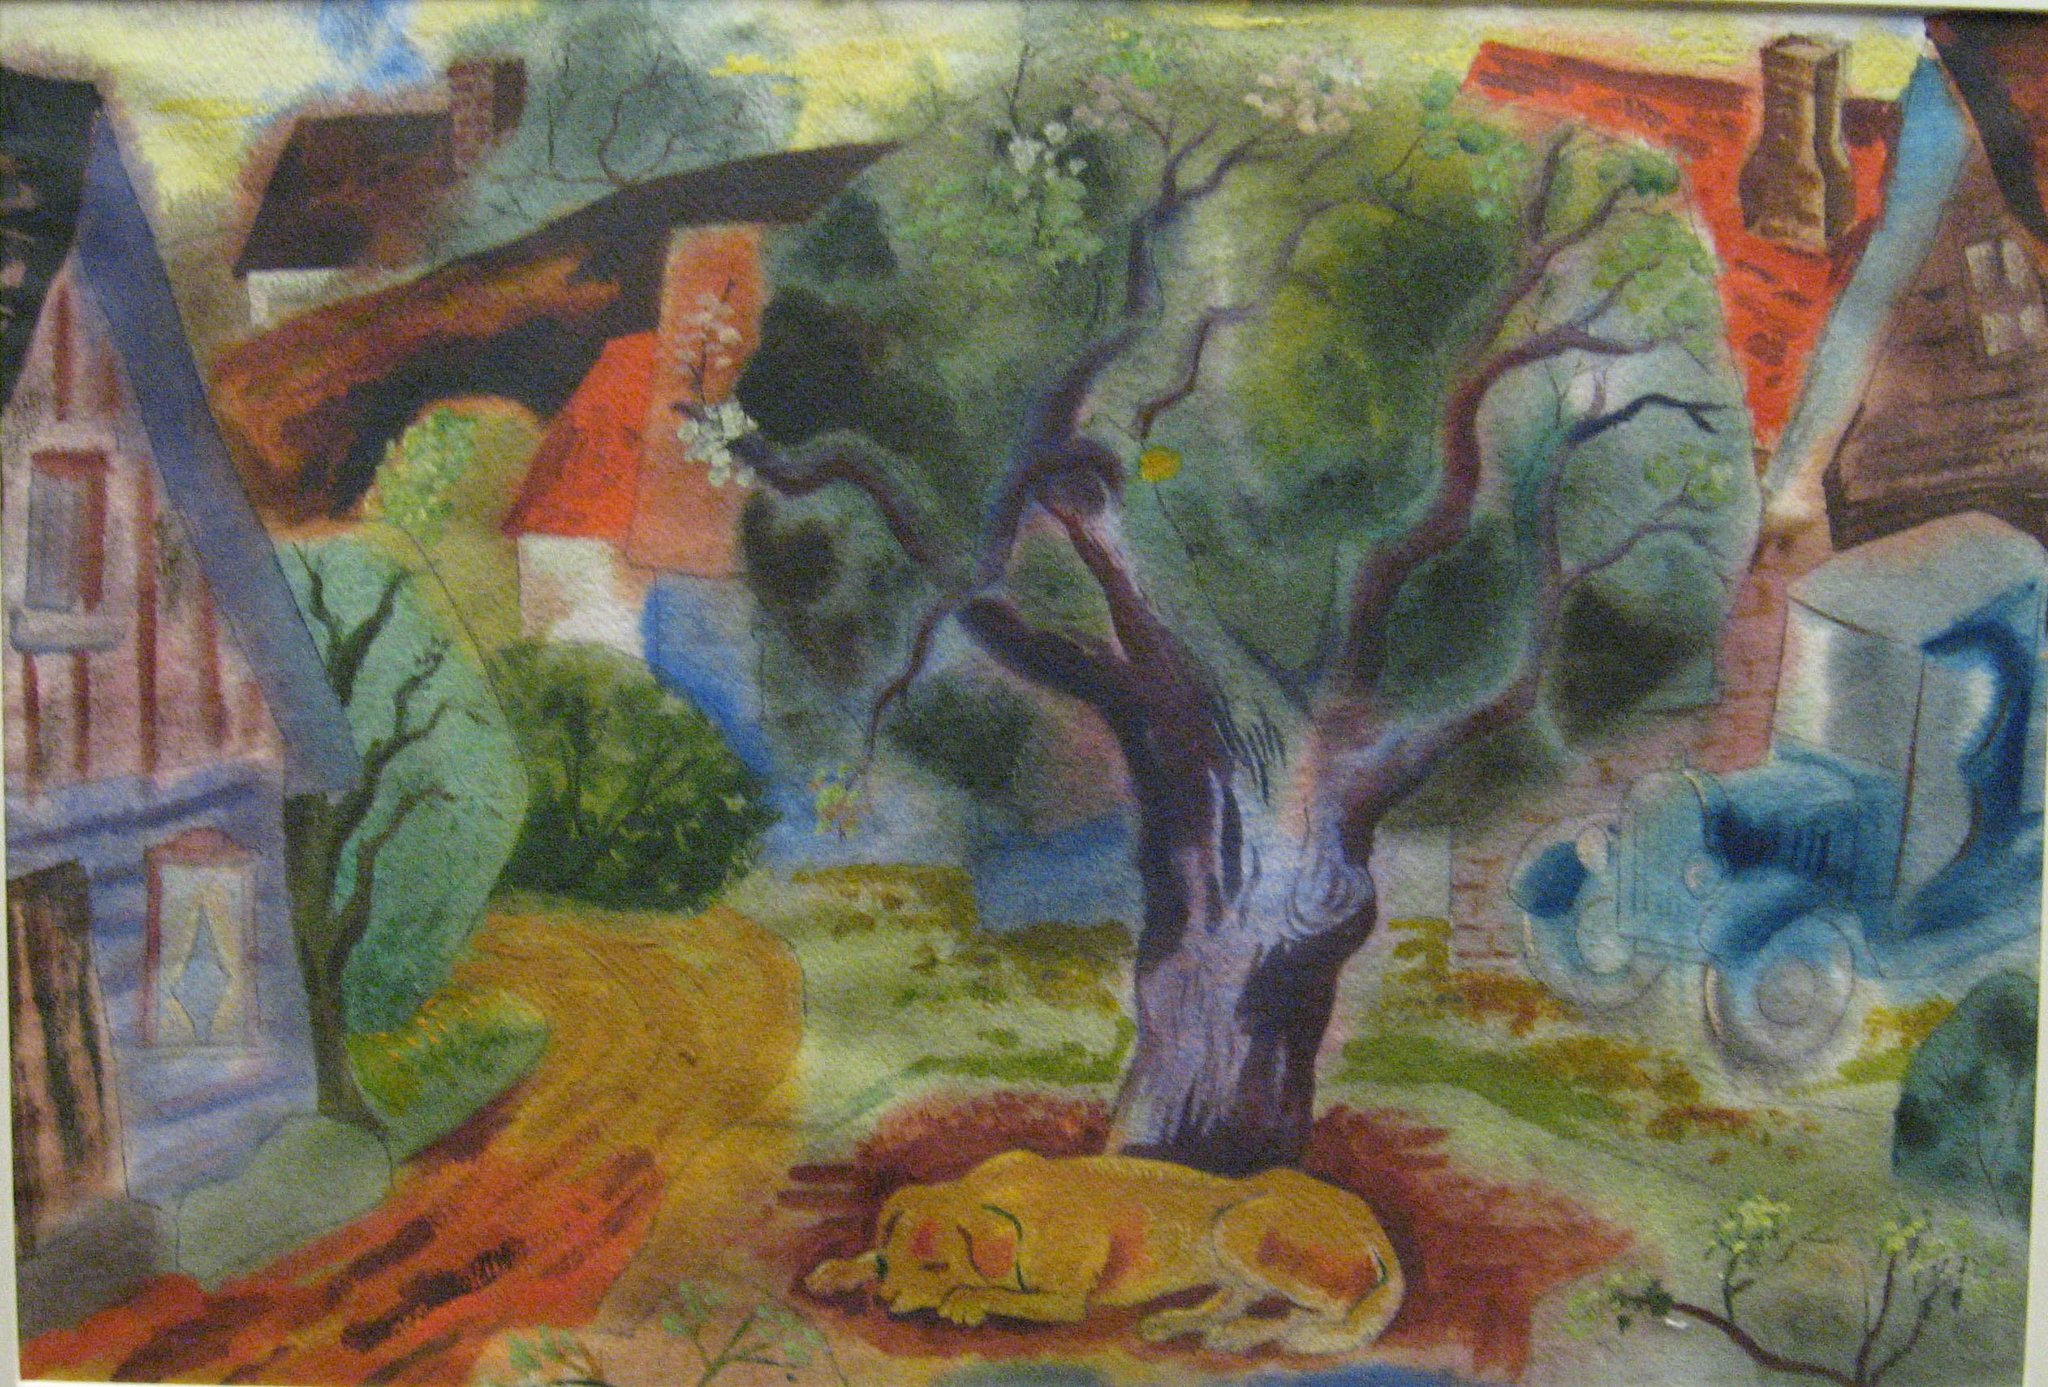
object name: drawing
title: Summer Day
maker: richard sussman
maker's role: artist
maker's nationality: american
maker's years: 1908-1971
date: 1939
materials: graphite, paper, watercolor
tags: buildings,houses,dogs,trees,summer,cars